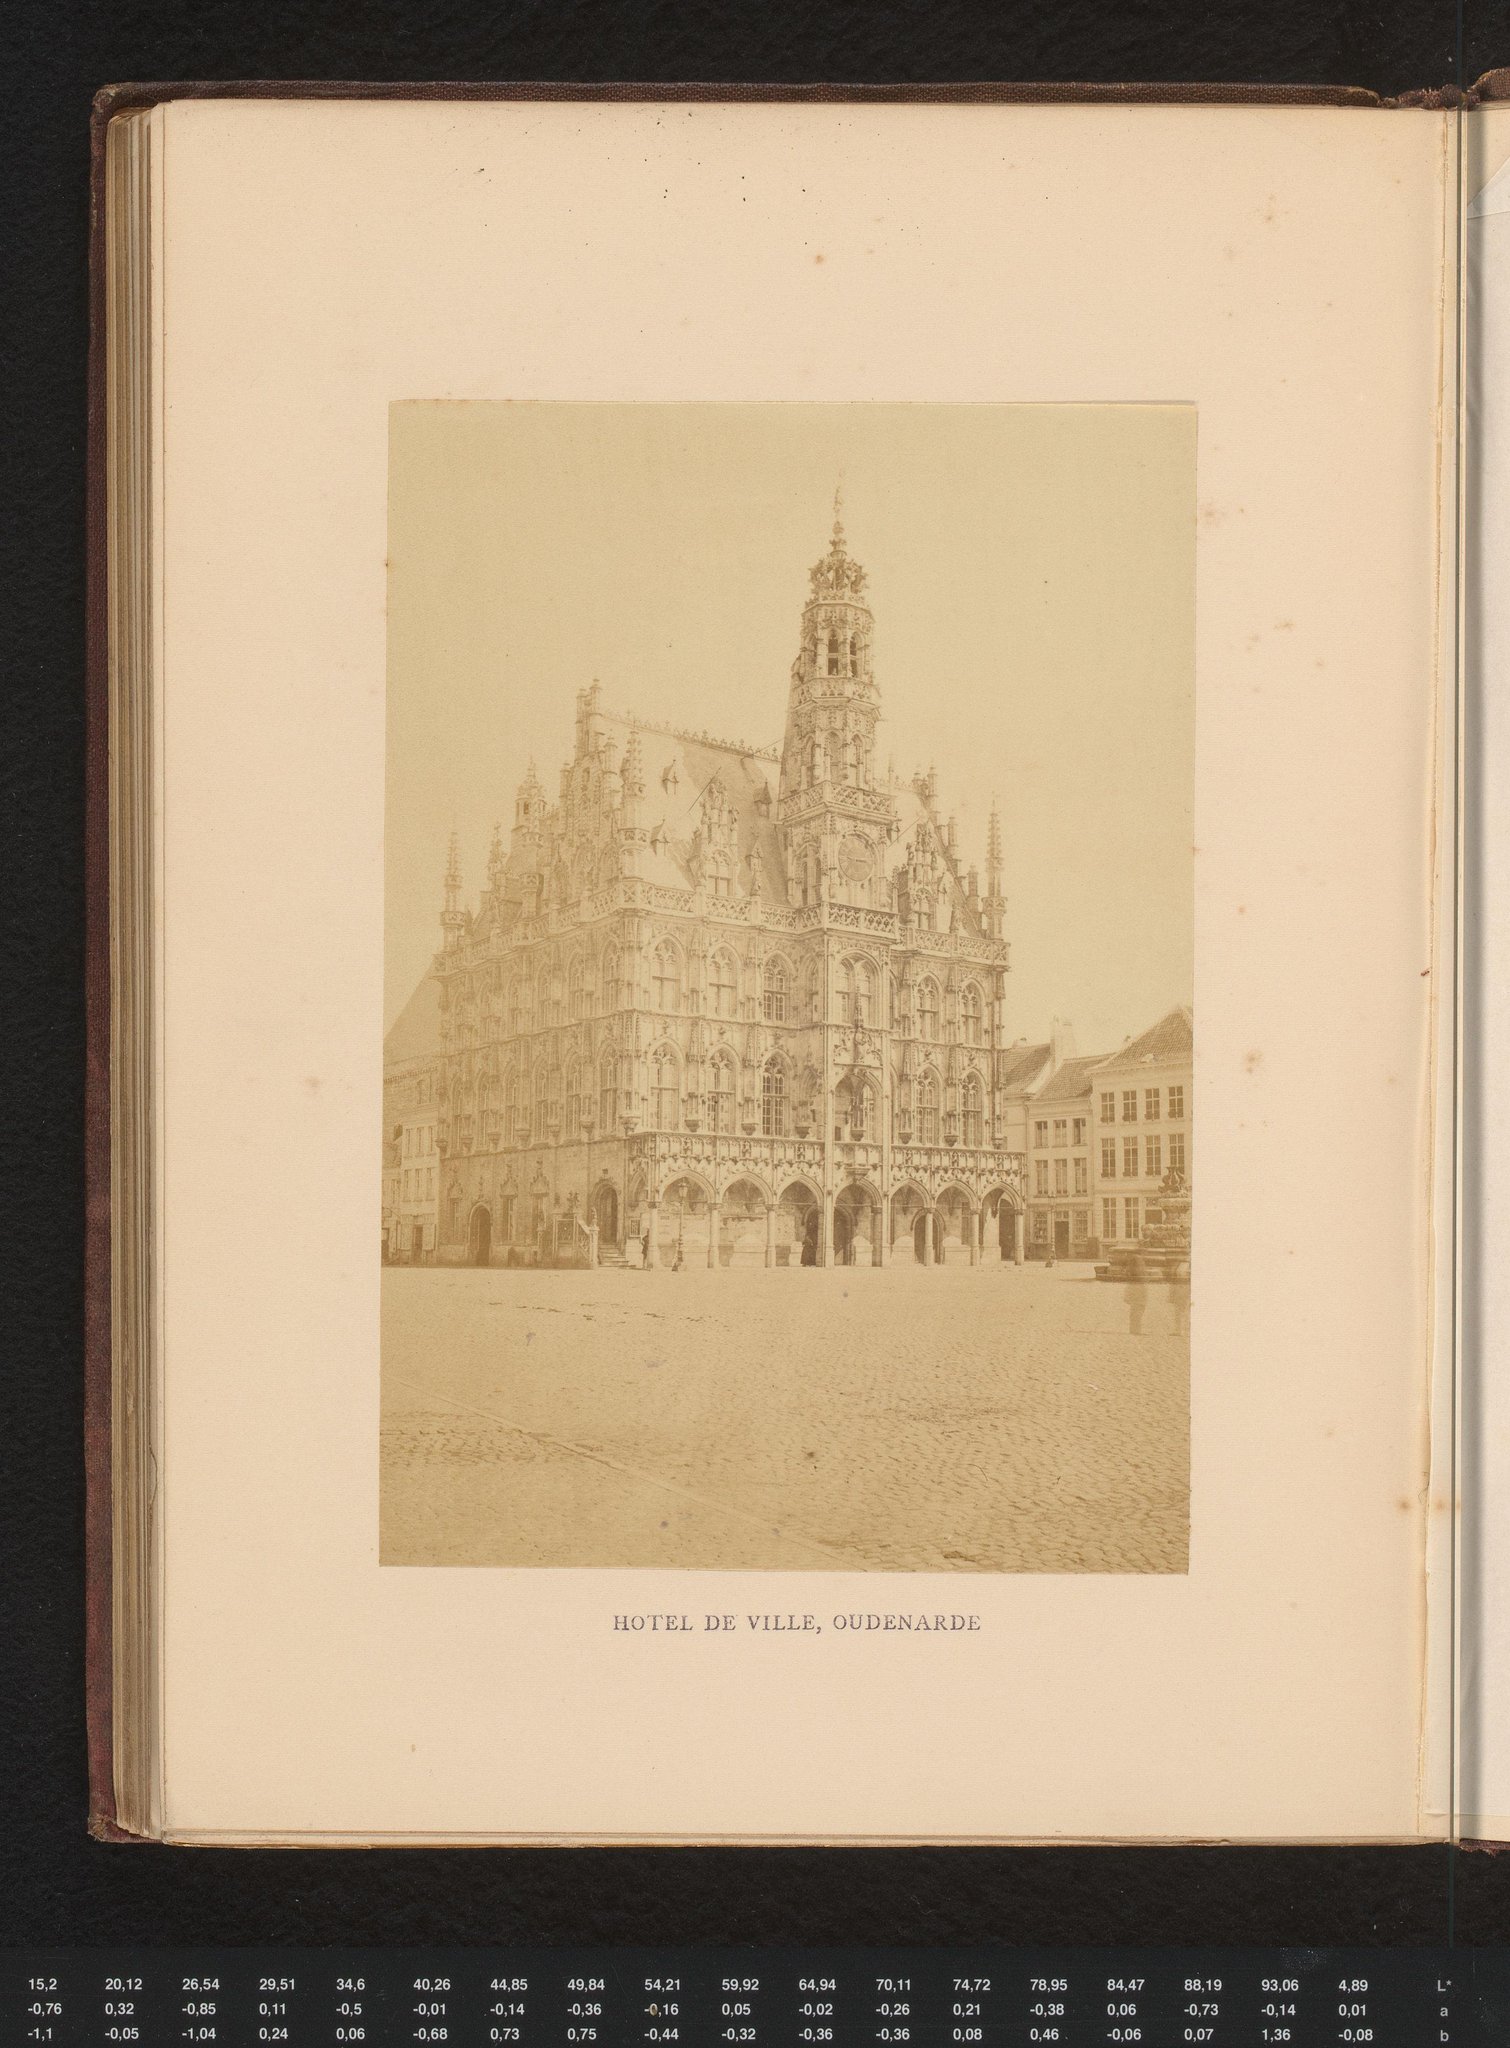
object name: page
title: Exterieur van het stadhuis van Oudenaarde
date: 1855-1866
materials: paper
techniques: albumen print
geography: oudenaarde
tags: townhall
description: Foto op tweede ongenummerde pagina na pagina 178.